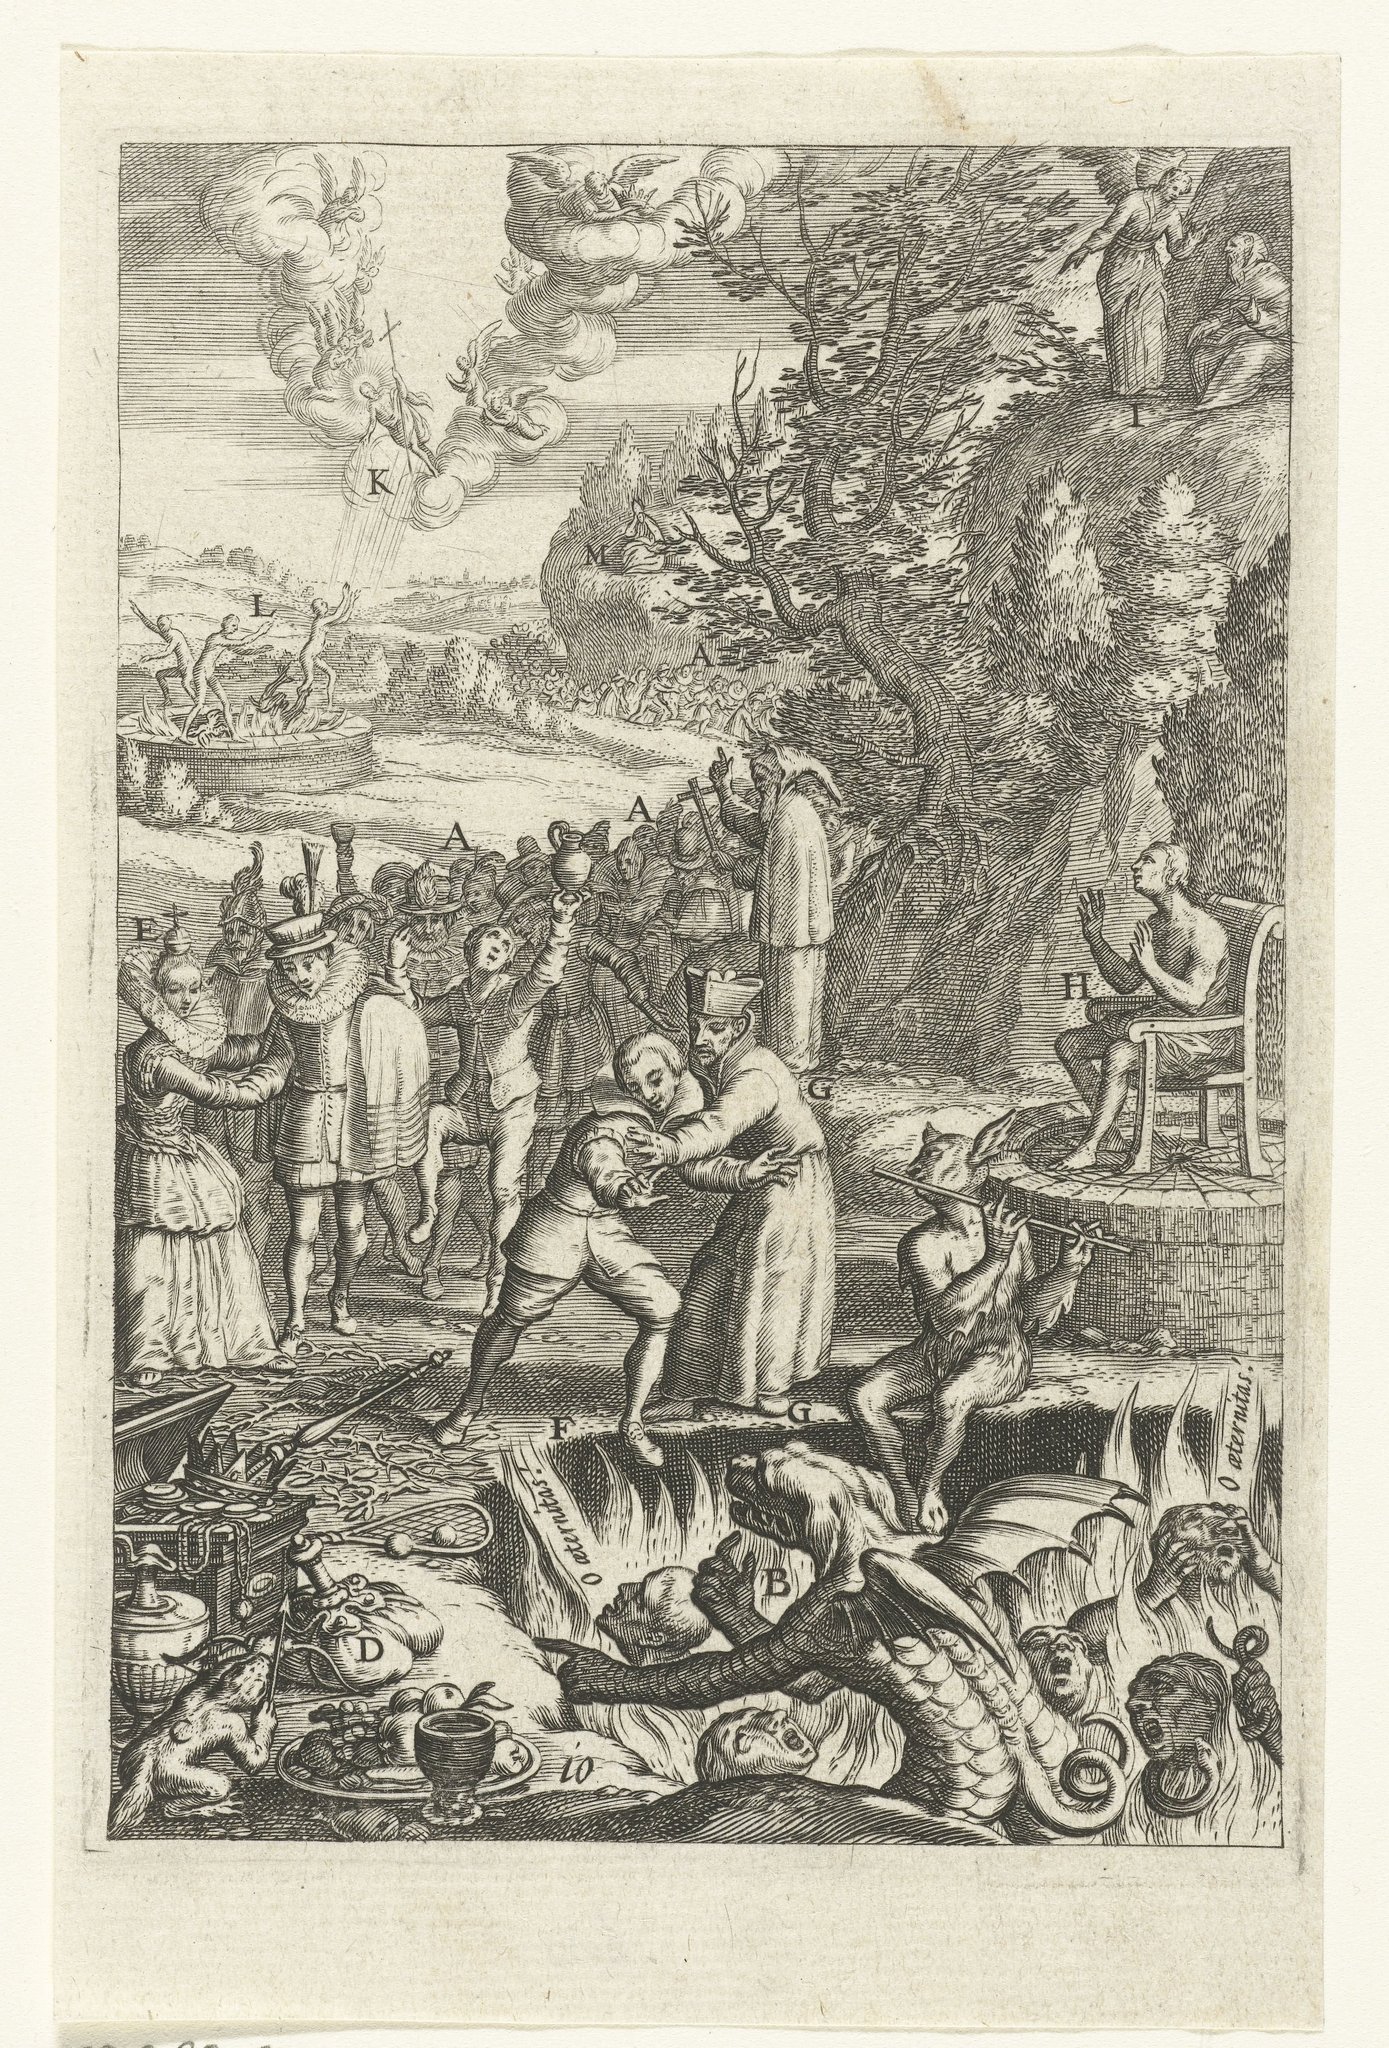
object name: print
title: Embleem met bisschop die een man beschermt tegen de verzoekingen van een duivel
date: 1620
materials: paper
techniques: engraving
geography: low countries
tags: the life of man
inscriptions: collector's mark: Lugt 2228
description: Een man staat op het randje van de afgrond bij het vagevuur en wordt door de duivel gelokt met rijkdom en overvloed. Een bisschop houdt hem echter tegen. Achter de man volgt een stoet losbandige mannen en vrouwen die gedoemd zijn tot het vagevuur.